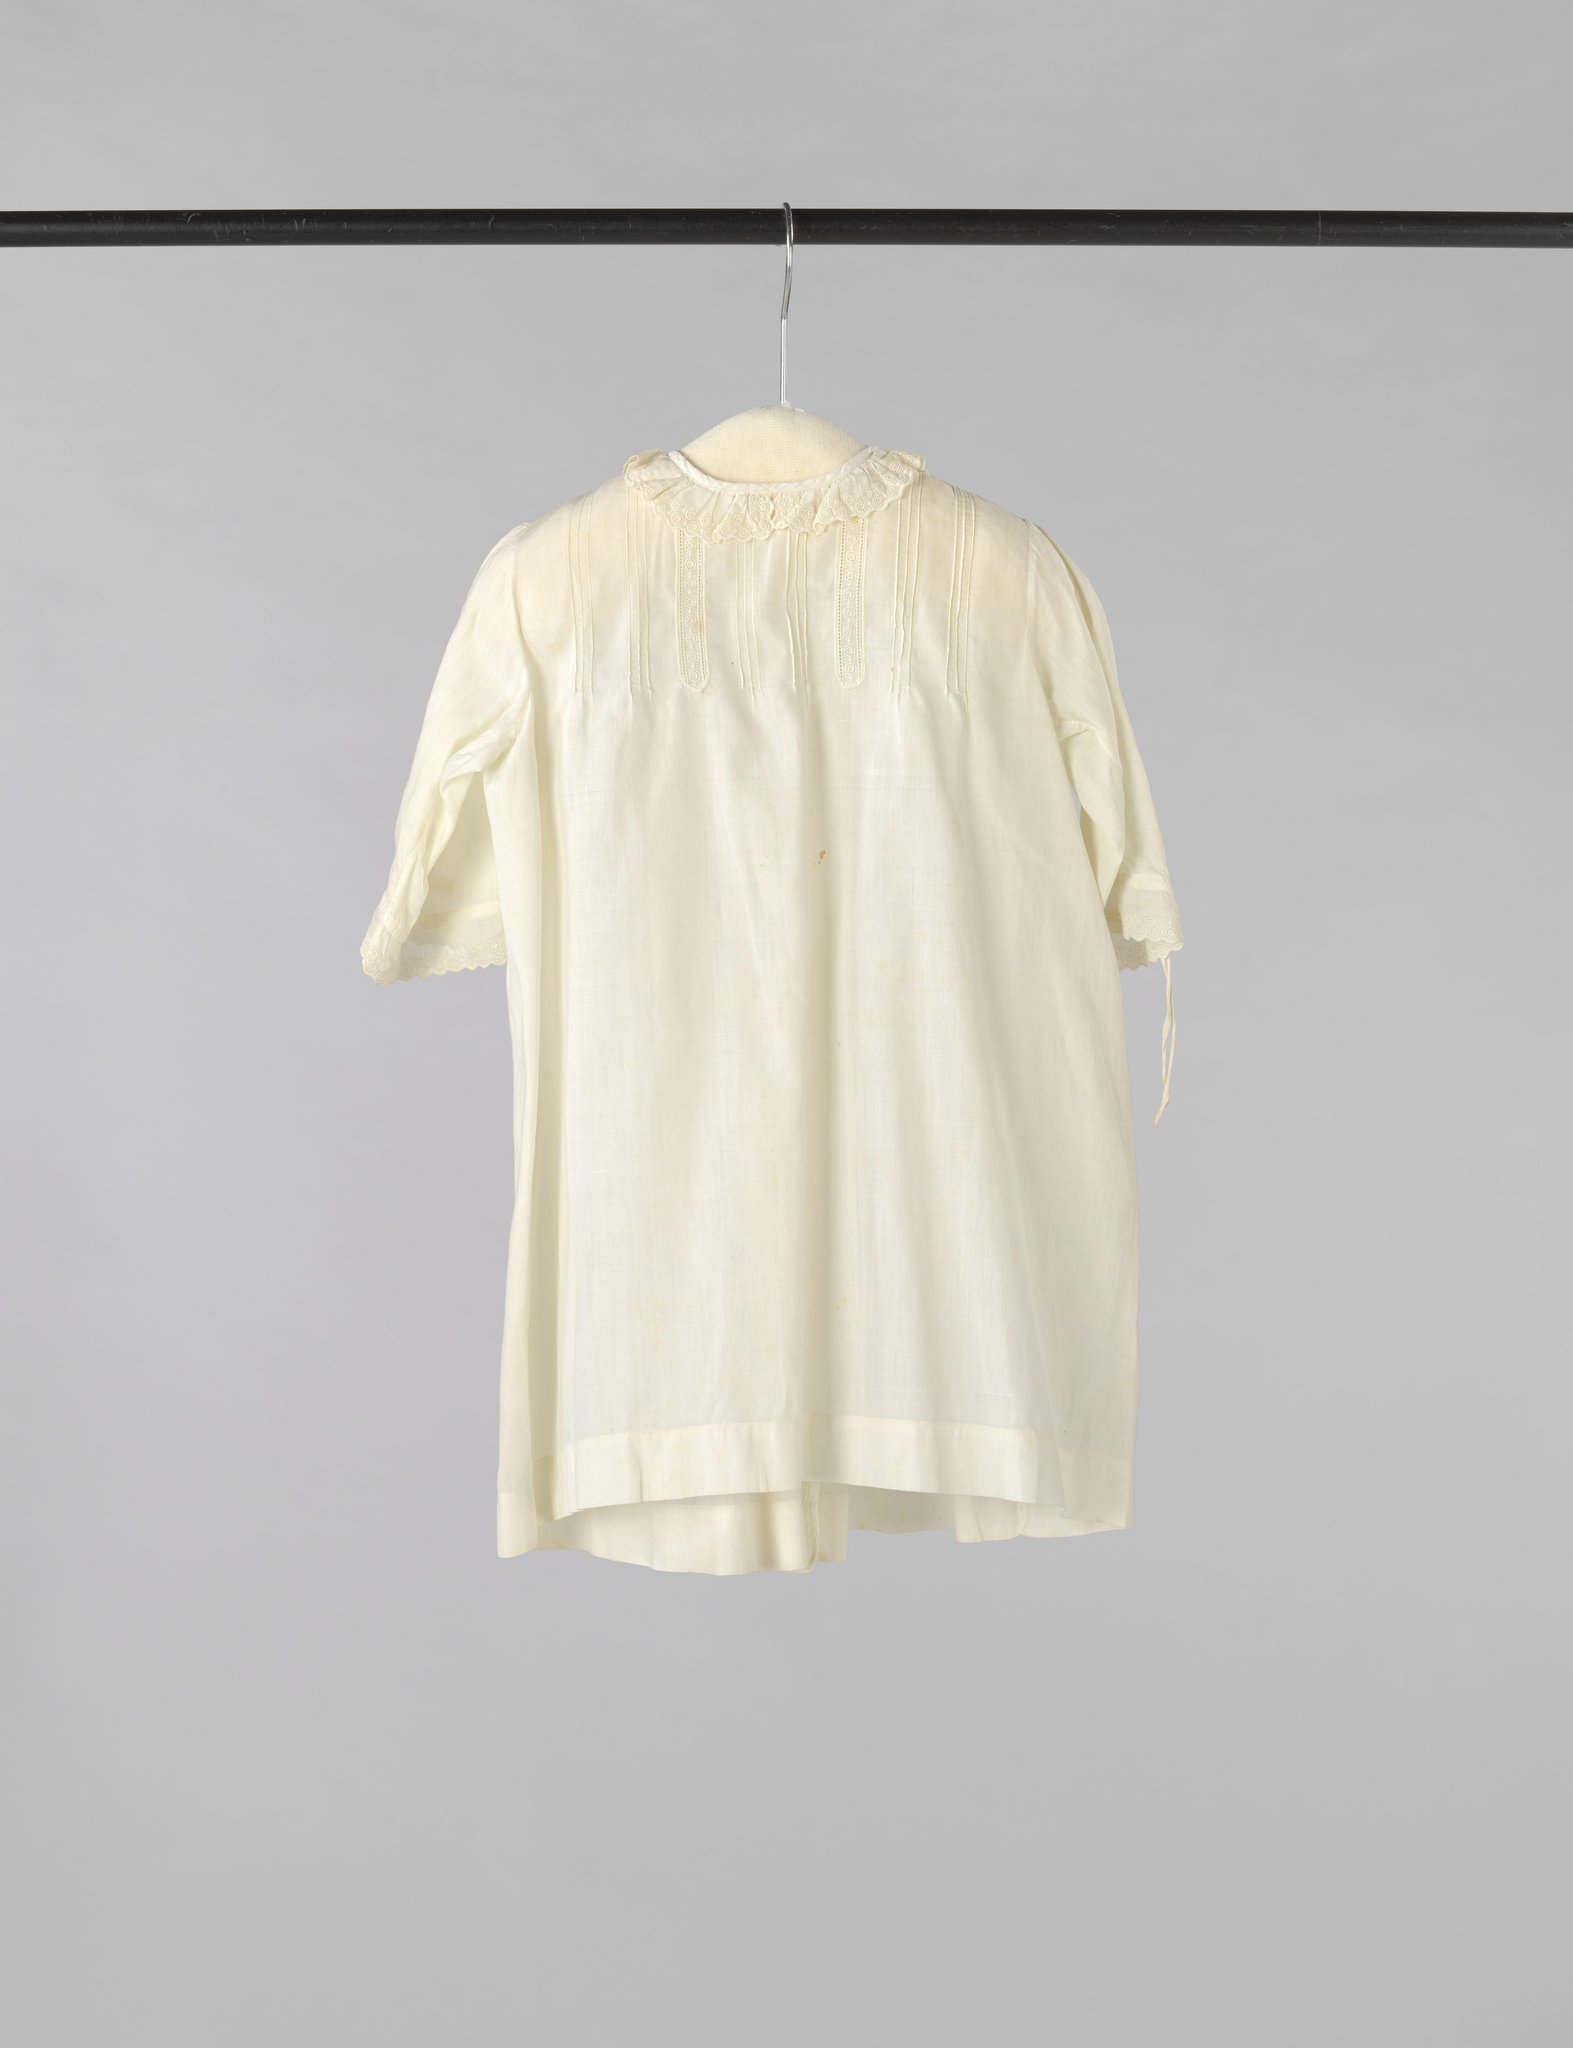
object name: apron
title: Kinderschort van wit katoen, versierd met tussenzetsels en stroken wit borduurwerk en oprijgen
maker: Anonymous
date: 1922-1926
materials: cotton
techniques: embroidered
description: Kinderschort van wit katoen, versierd met tussenzetsels en stroken wit borduurwerk en oprijgen.